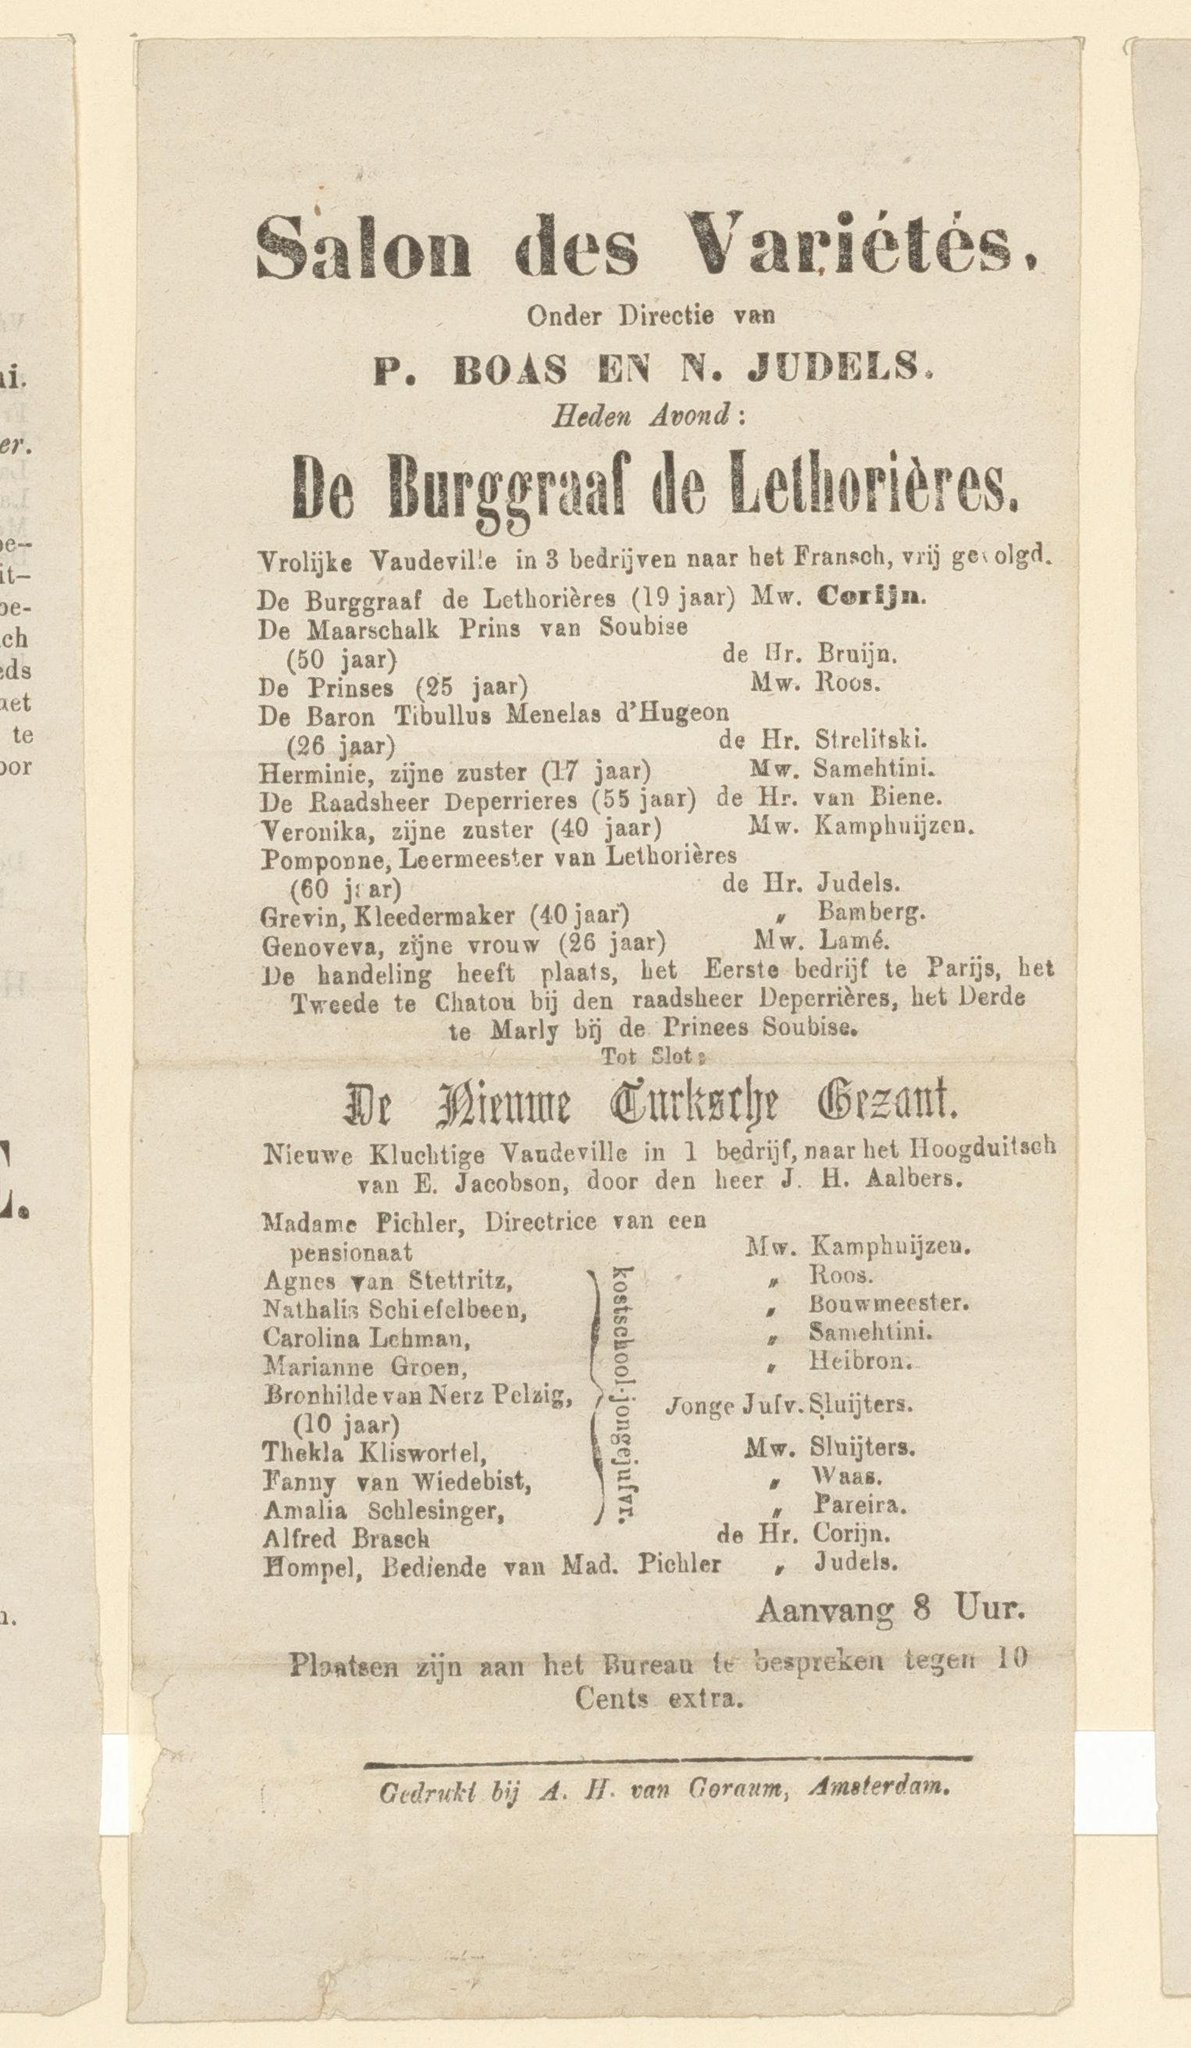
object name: text sheet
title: De Burggraaf de Lethorières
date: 1860-1869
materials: paper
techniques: letterpress printing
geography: amsterdam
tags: theatre, theatrical performance, art, amsterdam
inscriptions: stamp, collector's mark: Lugt 1641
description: Aankondiging van de voorstelling De Burggraaf de Lethorières. De voorstelling wordt opgevolgd door De Nieuwe Turksche Gezant. Onderwerpsrubrieken binnen de Atlas Zeden en Gewoonten: Tooneel, Toneelprogramma’s.